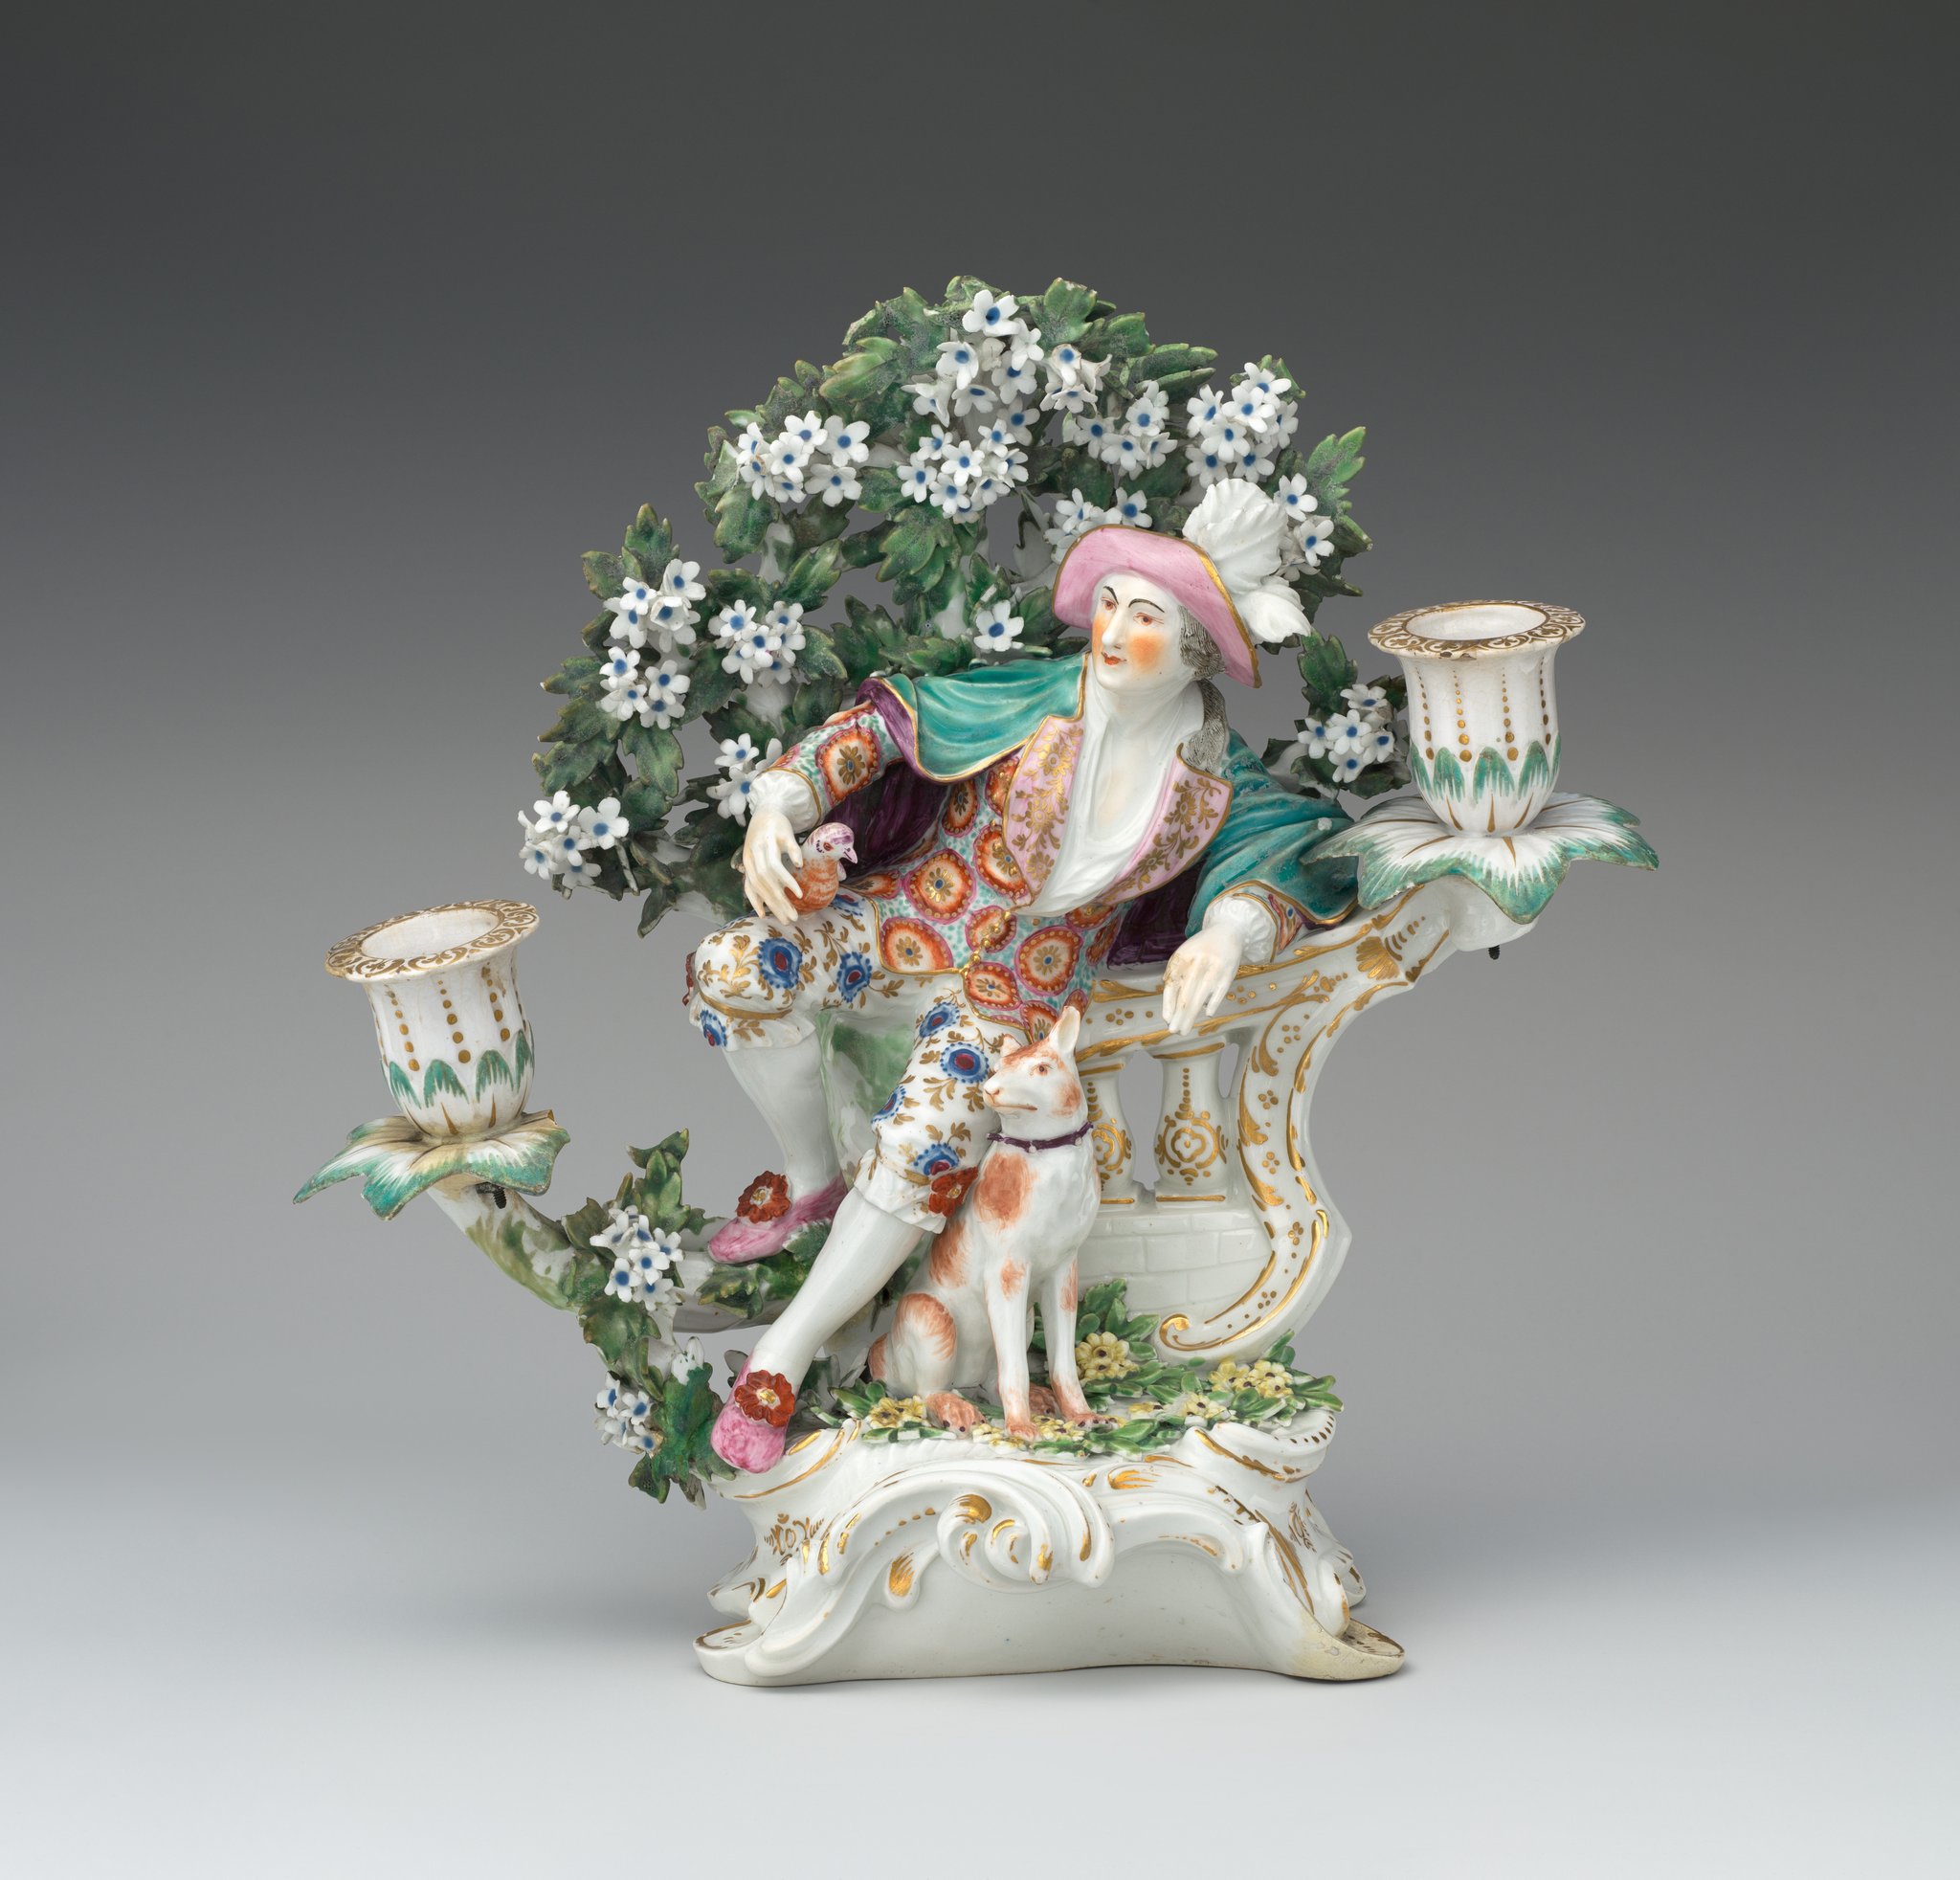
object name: candelabrum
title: Candelabrum (one of a pair)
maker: derby porcelain manufactory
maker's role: factory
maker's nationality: british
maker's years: 1751-1785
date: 1701-1800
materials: soft paste porcelain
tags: birds,men,dogs